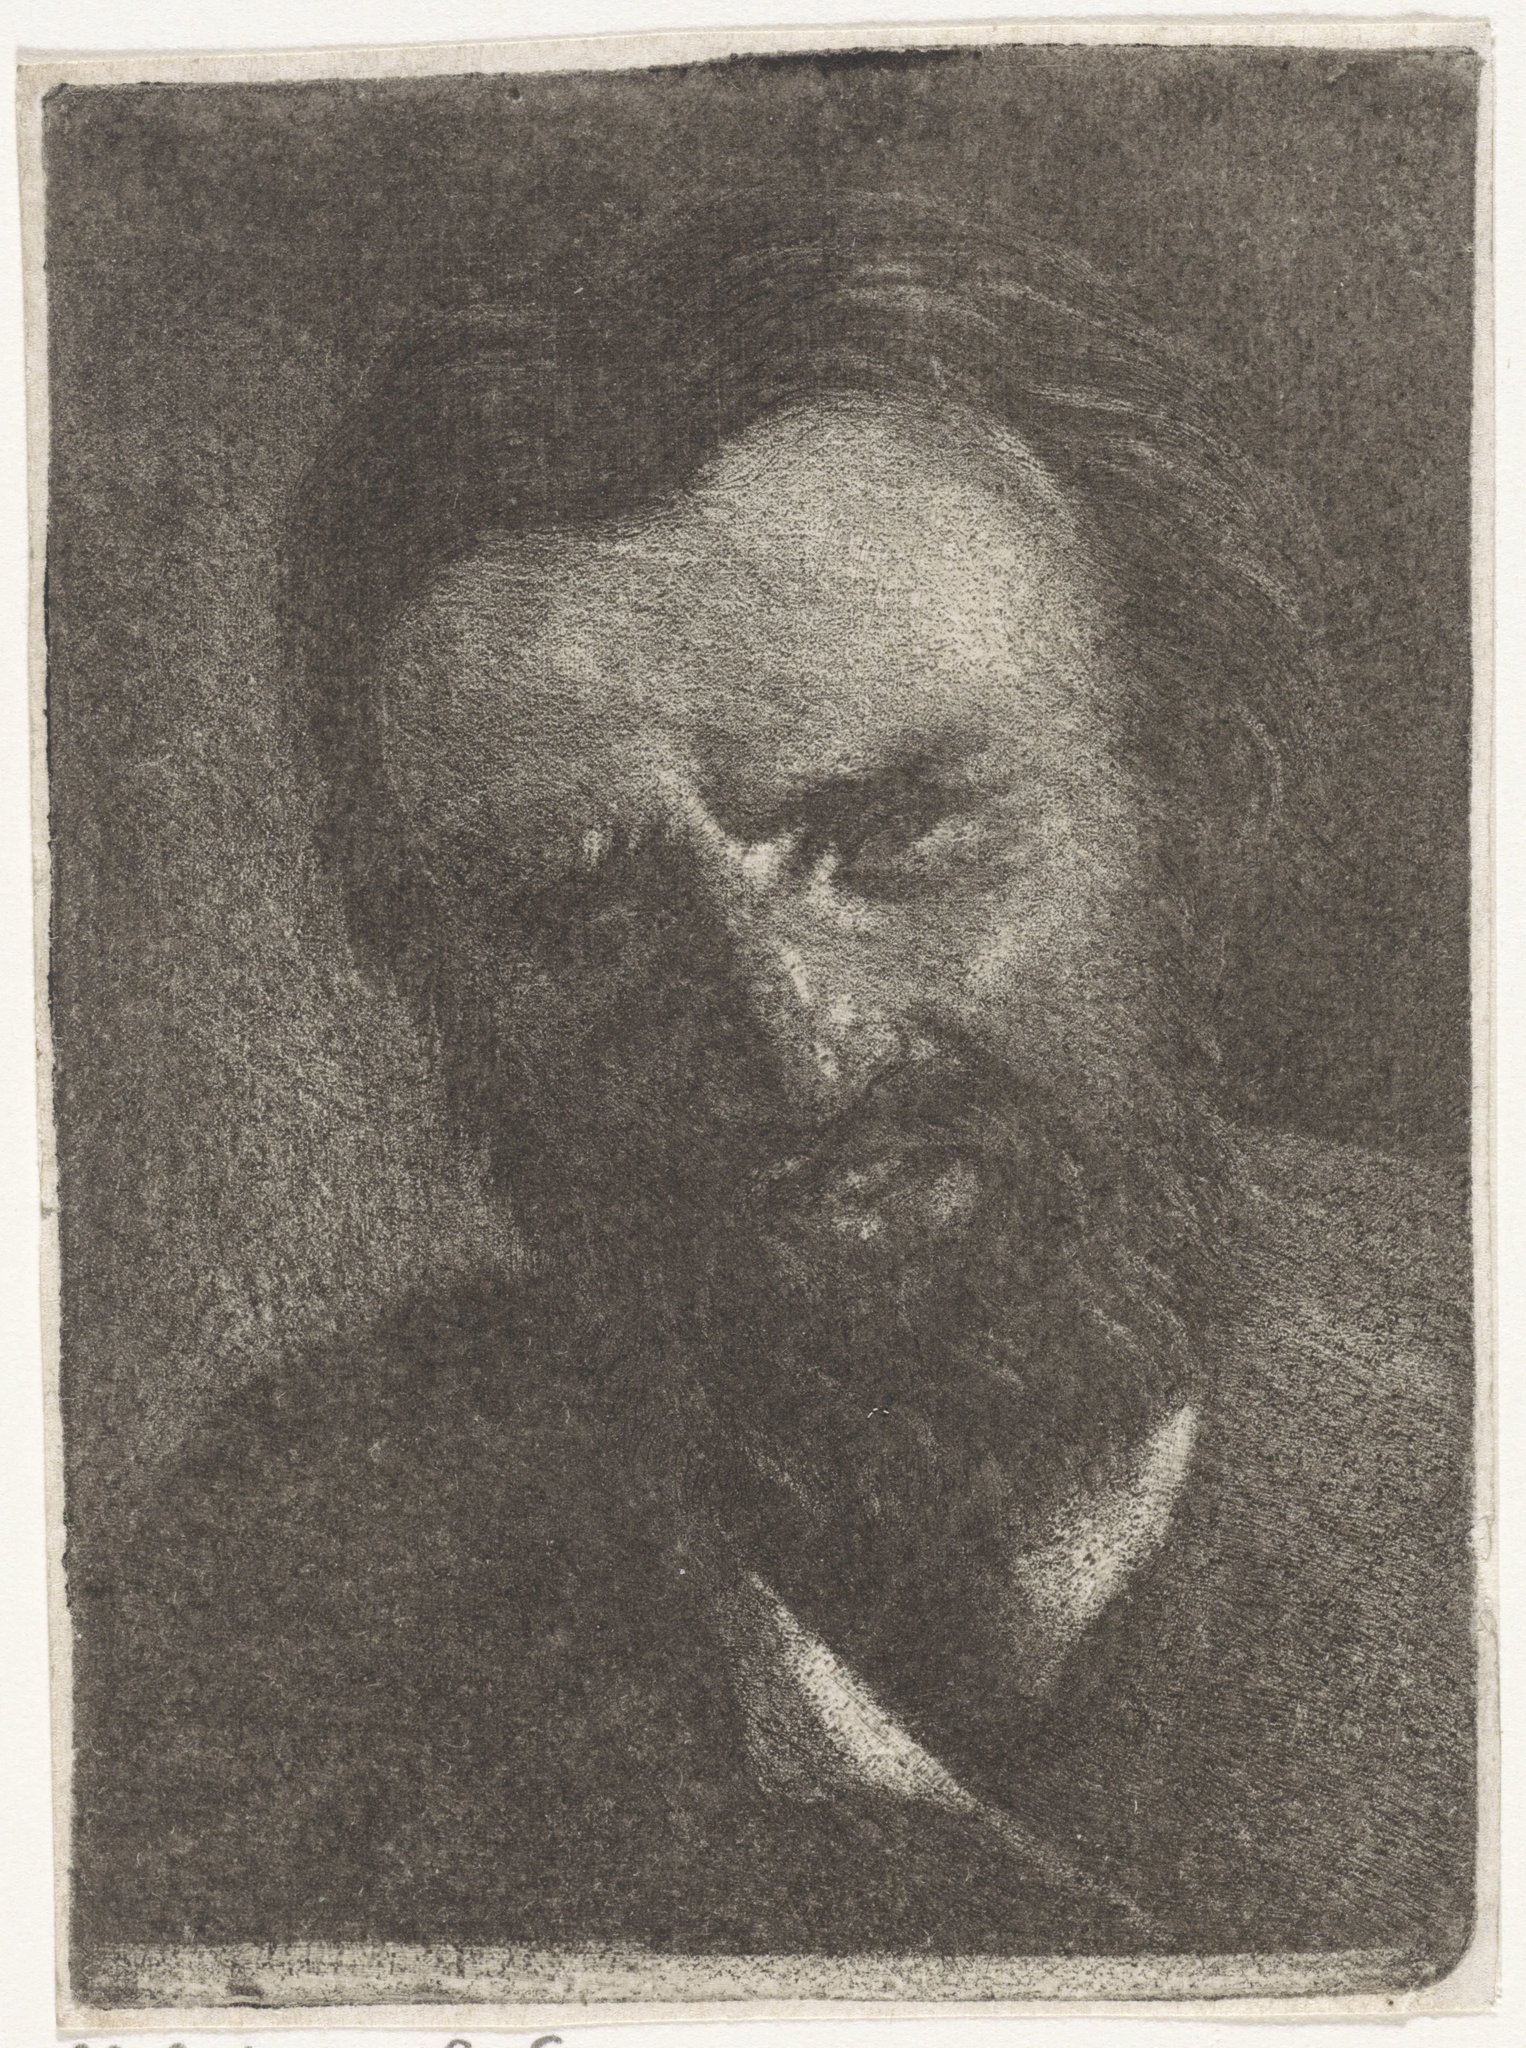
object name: print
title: Kop van een man met een korte baard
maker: Anonymous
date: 1680-1800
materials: paper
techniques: mezzotint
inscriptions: collector's mark: Lugt 2228